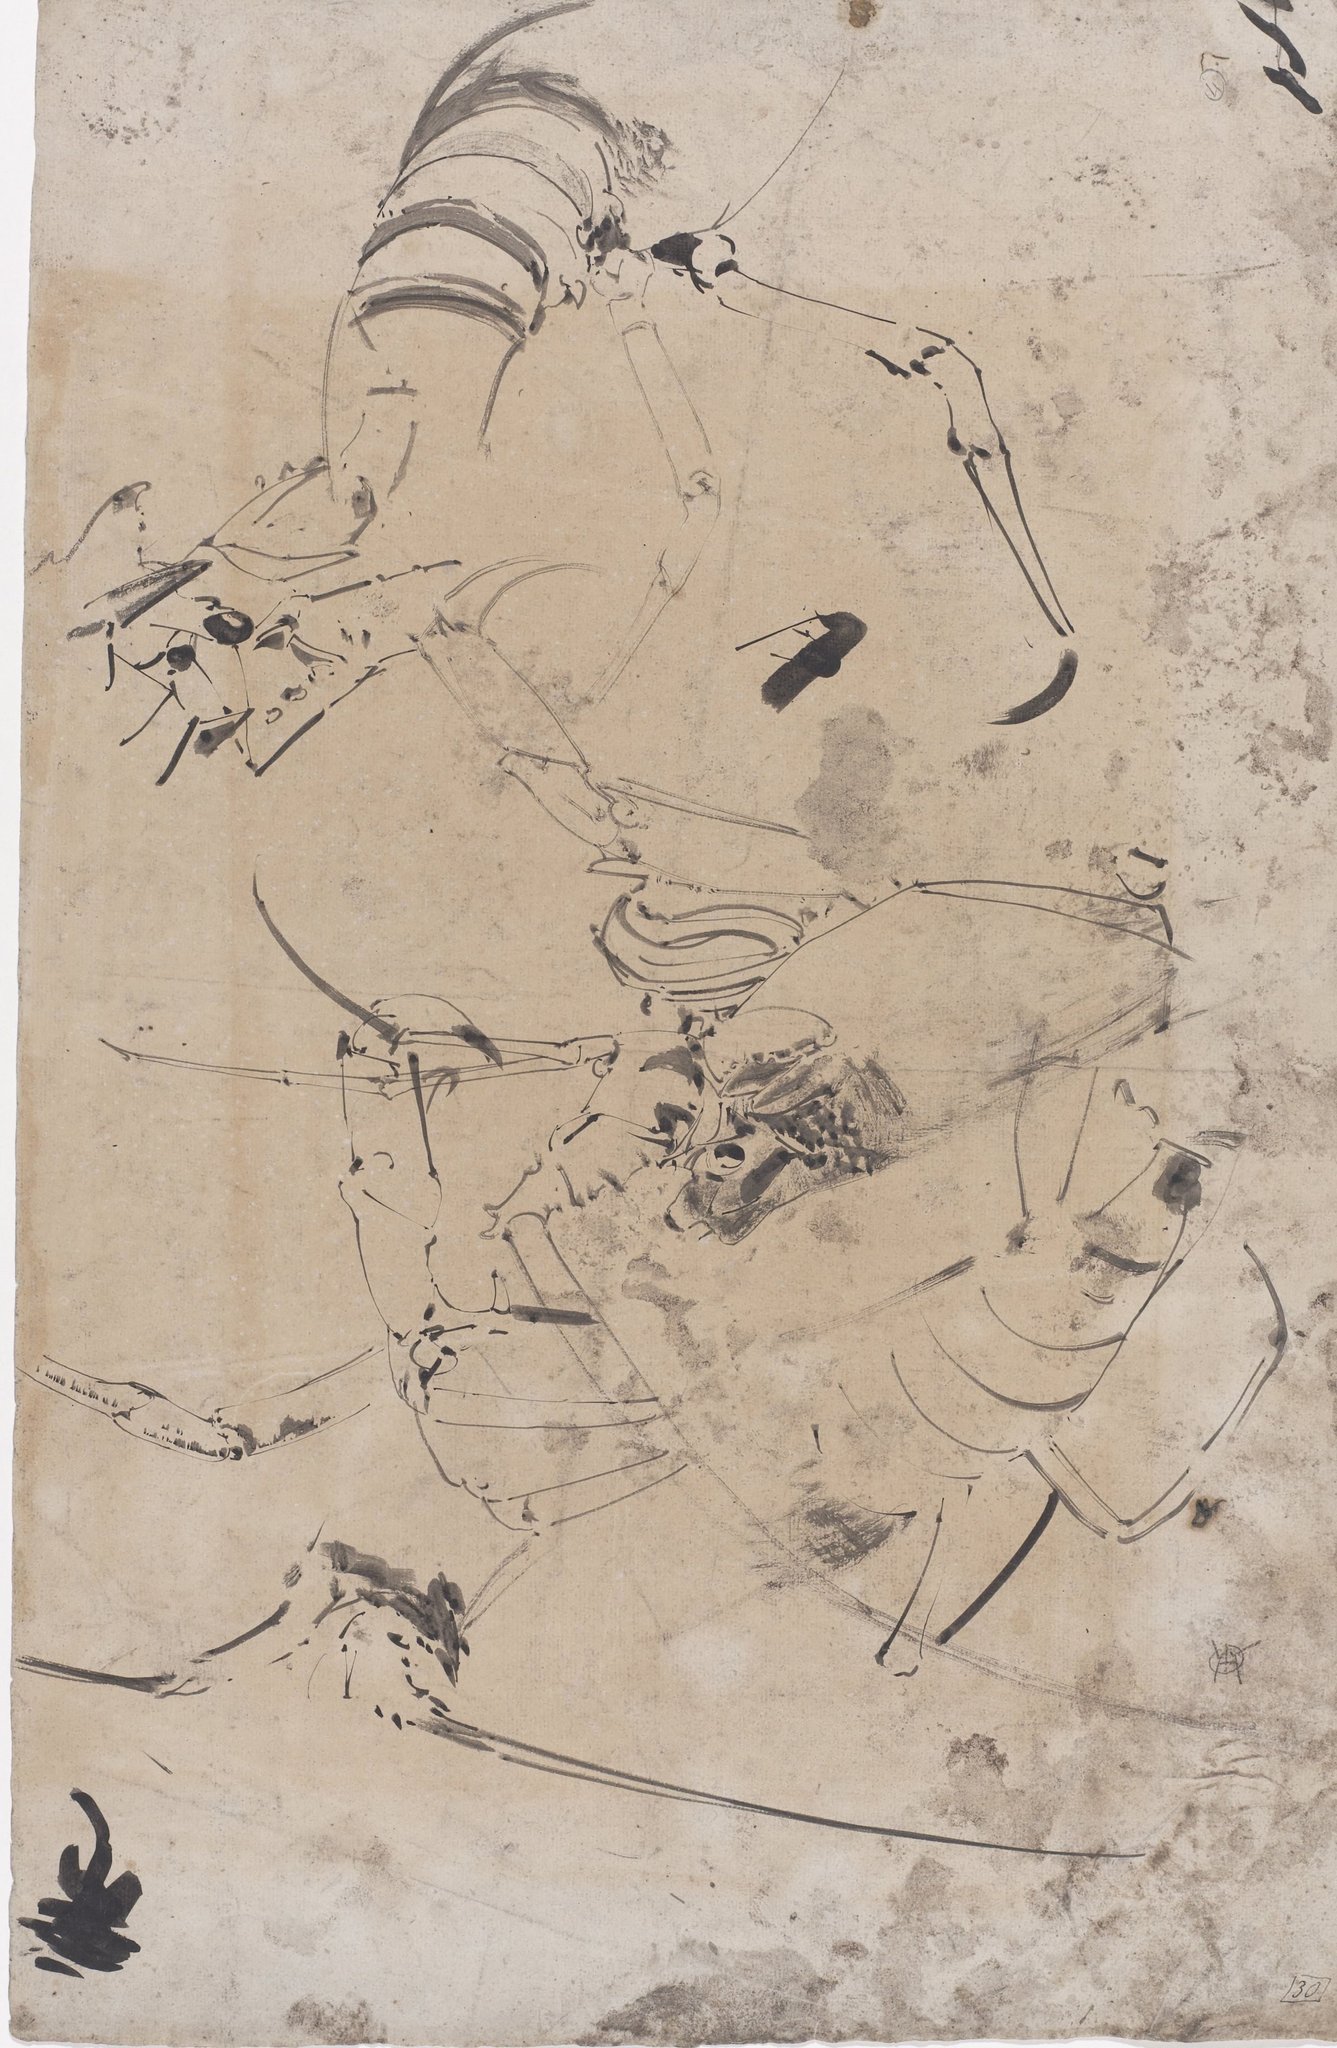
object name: drawing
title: Studieblad met kreeften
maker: gerrit willem dijsselhof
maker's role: designer, draughtsman, print maker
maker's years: 1866-1924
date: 1876-1924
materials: paper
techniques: brush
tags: crustaceans